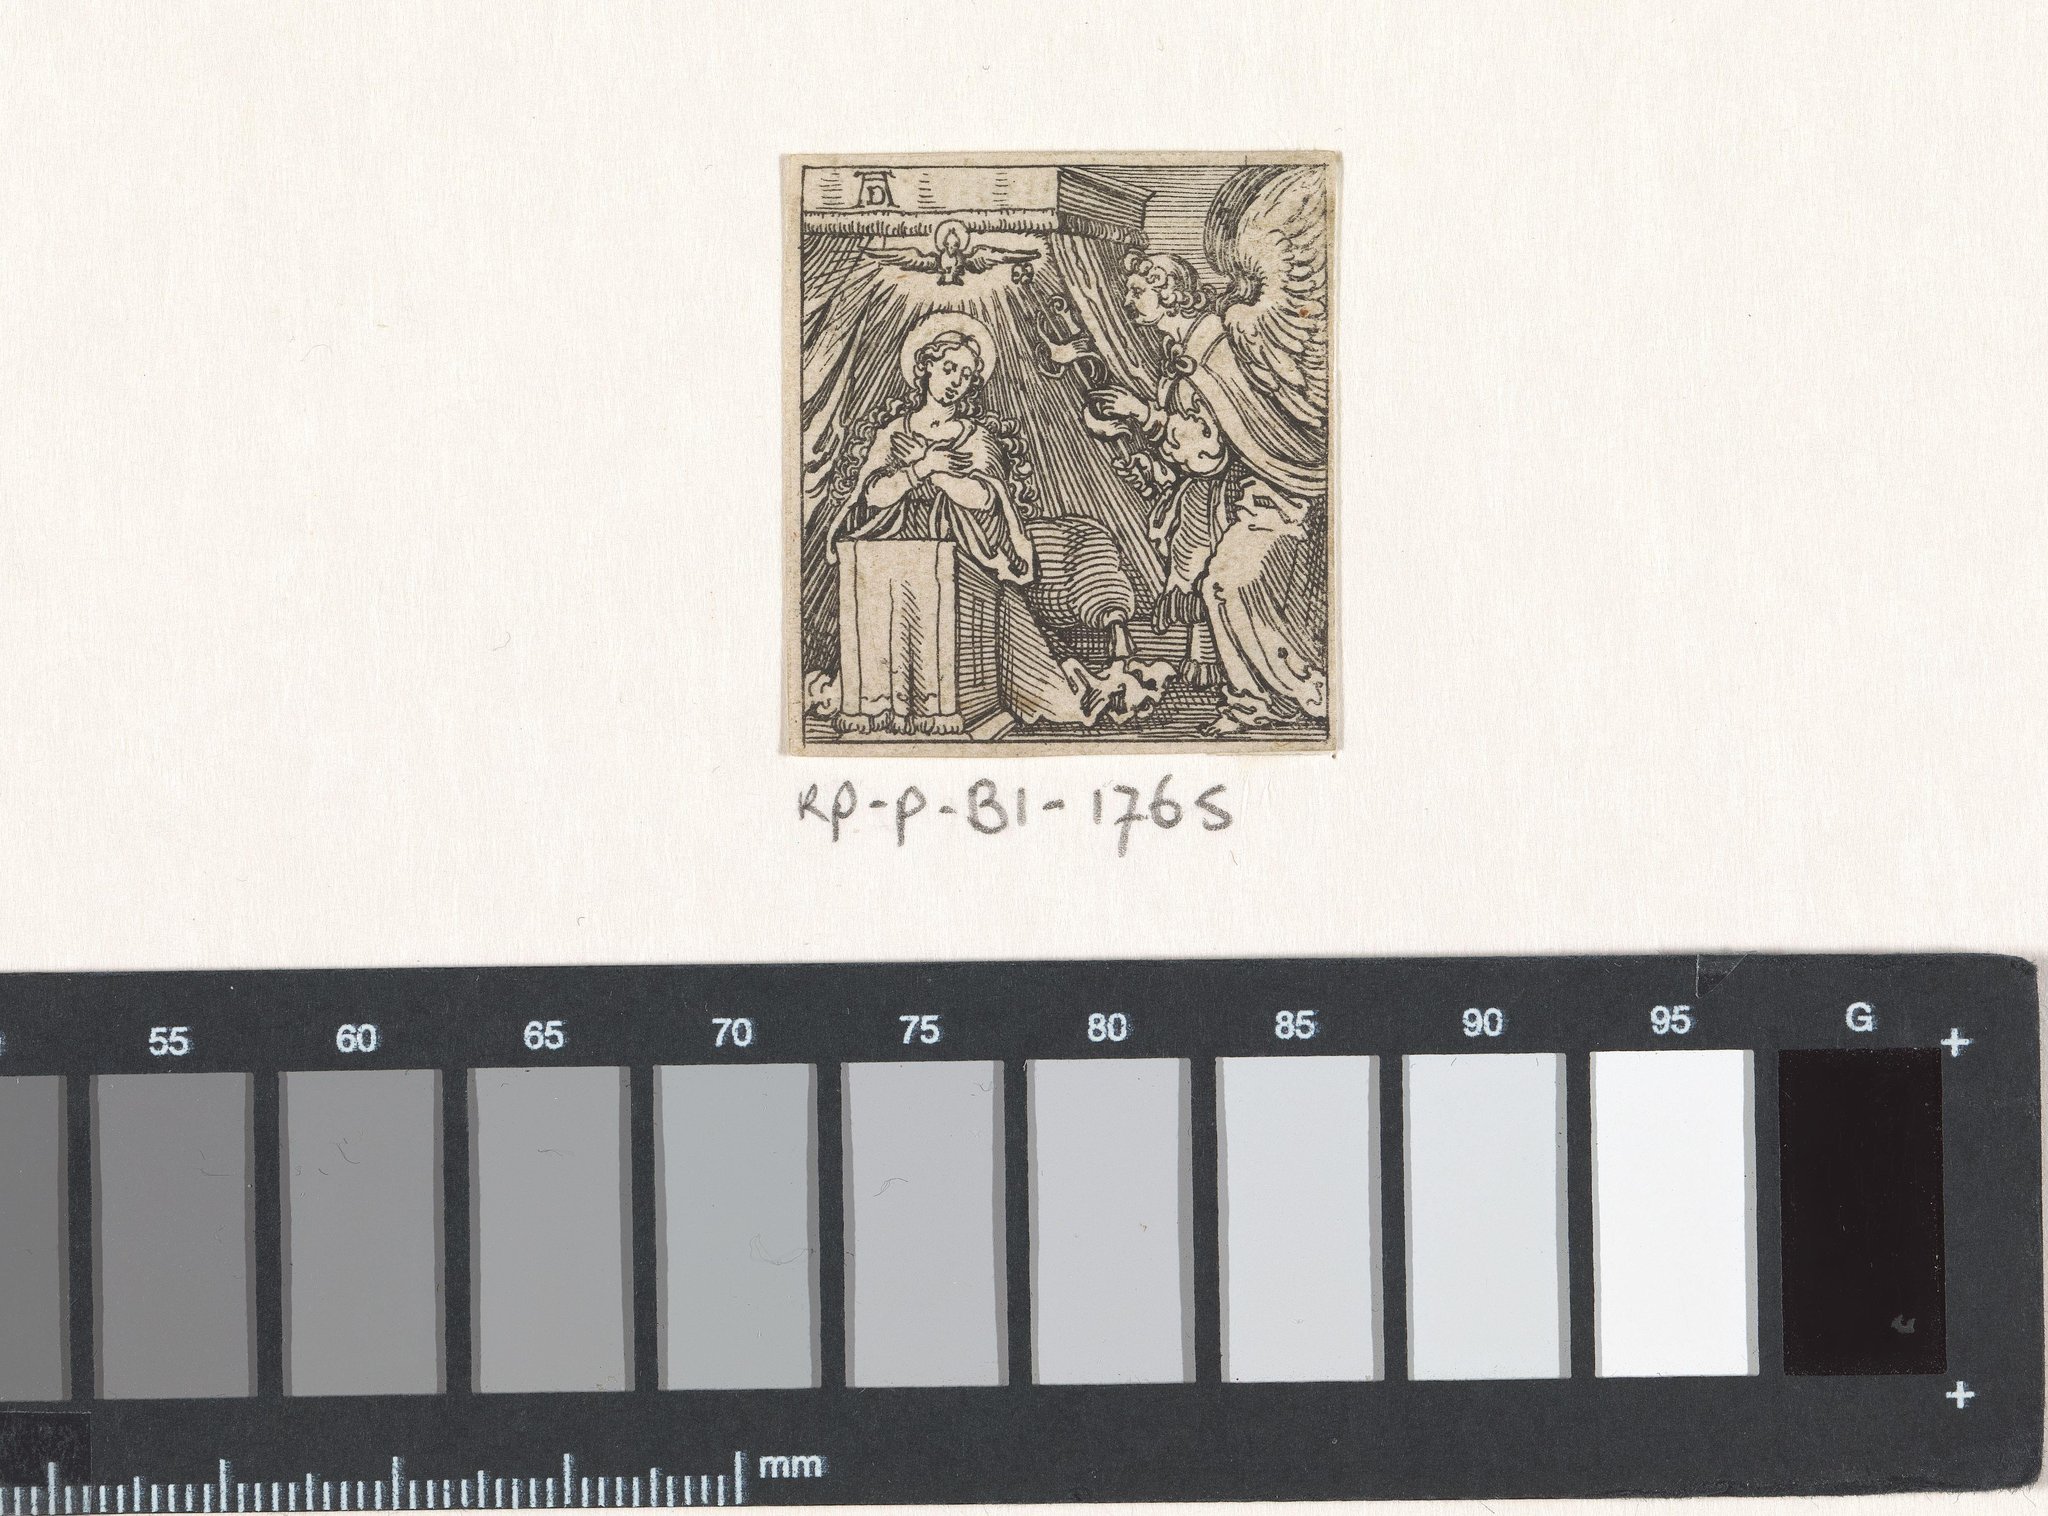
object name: print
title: Annunciatie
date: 1597-1656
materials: paper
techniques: etching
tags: the annunciation: mary, usually reading, is visited by the angel (sometimes a woman overhears the conversation)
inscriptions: collector's mark: Lugt 240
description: De aankondiging van de geboorte van Christus aan Maria. De engel Gabriël verschijnt aan Maria die geknield zit te lezen. Boven Maria's hoofd de Heilige Geest in de gedaante van een duif. De prent maakt deel uit van een twaalfdelige serie prenten met scènes uit het leven van Christus en de Maagd Maria.